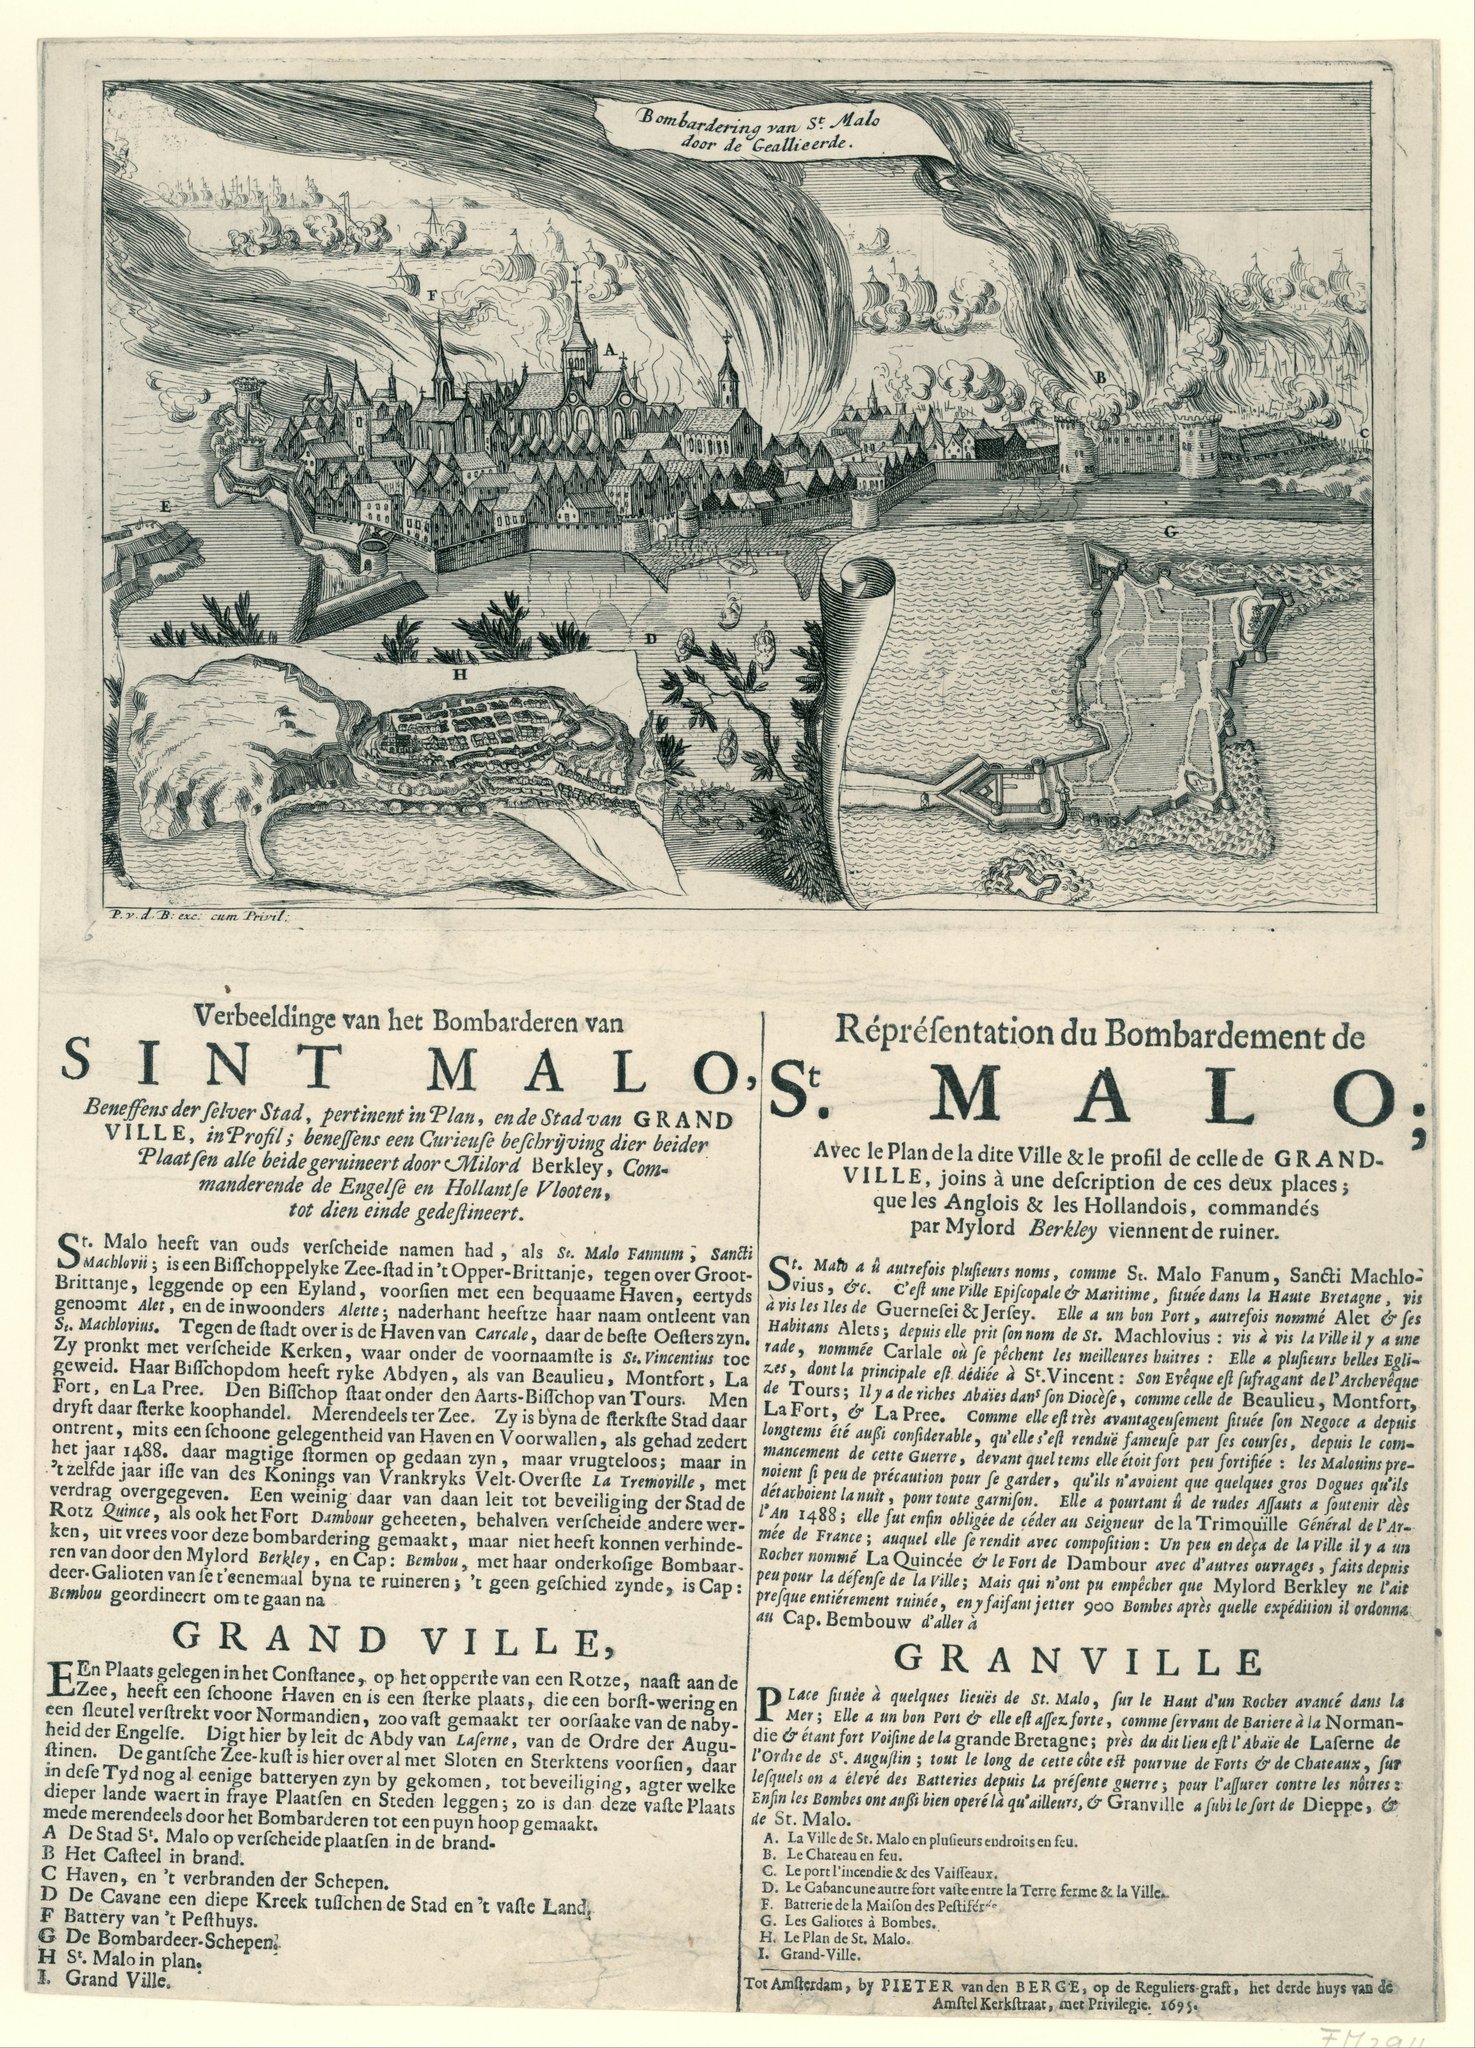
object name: print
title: Bombardement van Saint-Malo, 1695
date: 1695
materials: paper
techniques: engraving, etching, letterpress printing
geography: amsterdam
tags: bombardment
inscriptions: date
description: Het bombarderen van de Franse stad Saint-Malo in Bretagne door de gecombineerde Engelse en Nederlandse vloot op 14-15 juli 1695. Op het blad onder de plaat Nederlandse en Franse beschrijvingen van Saint-Malo en het nabij gelegen Granville.